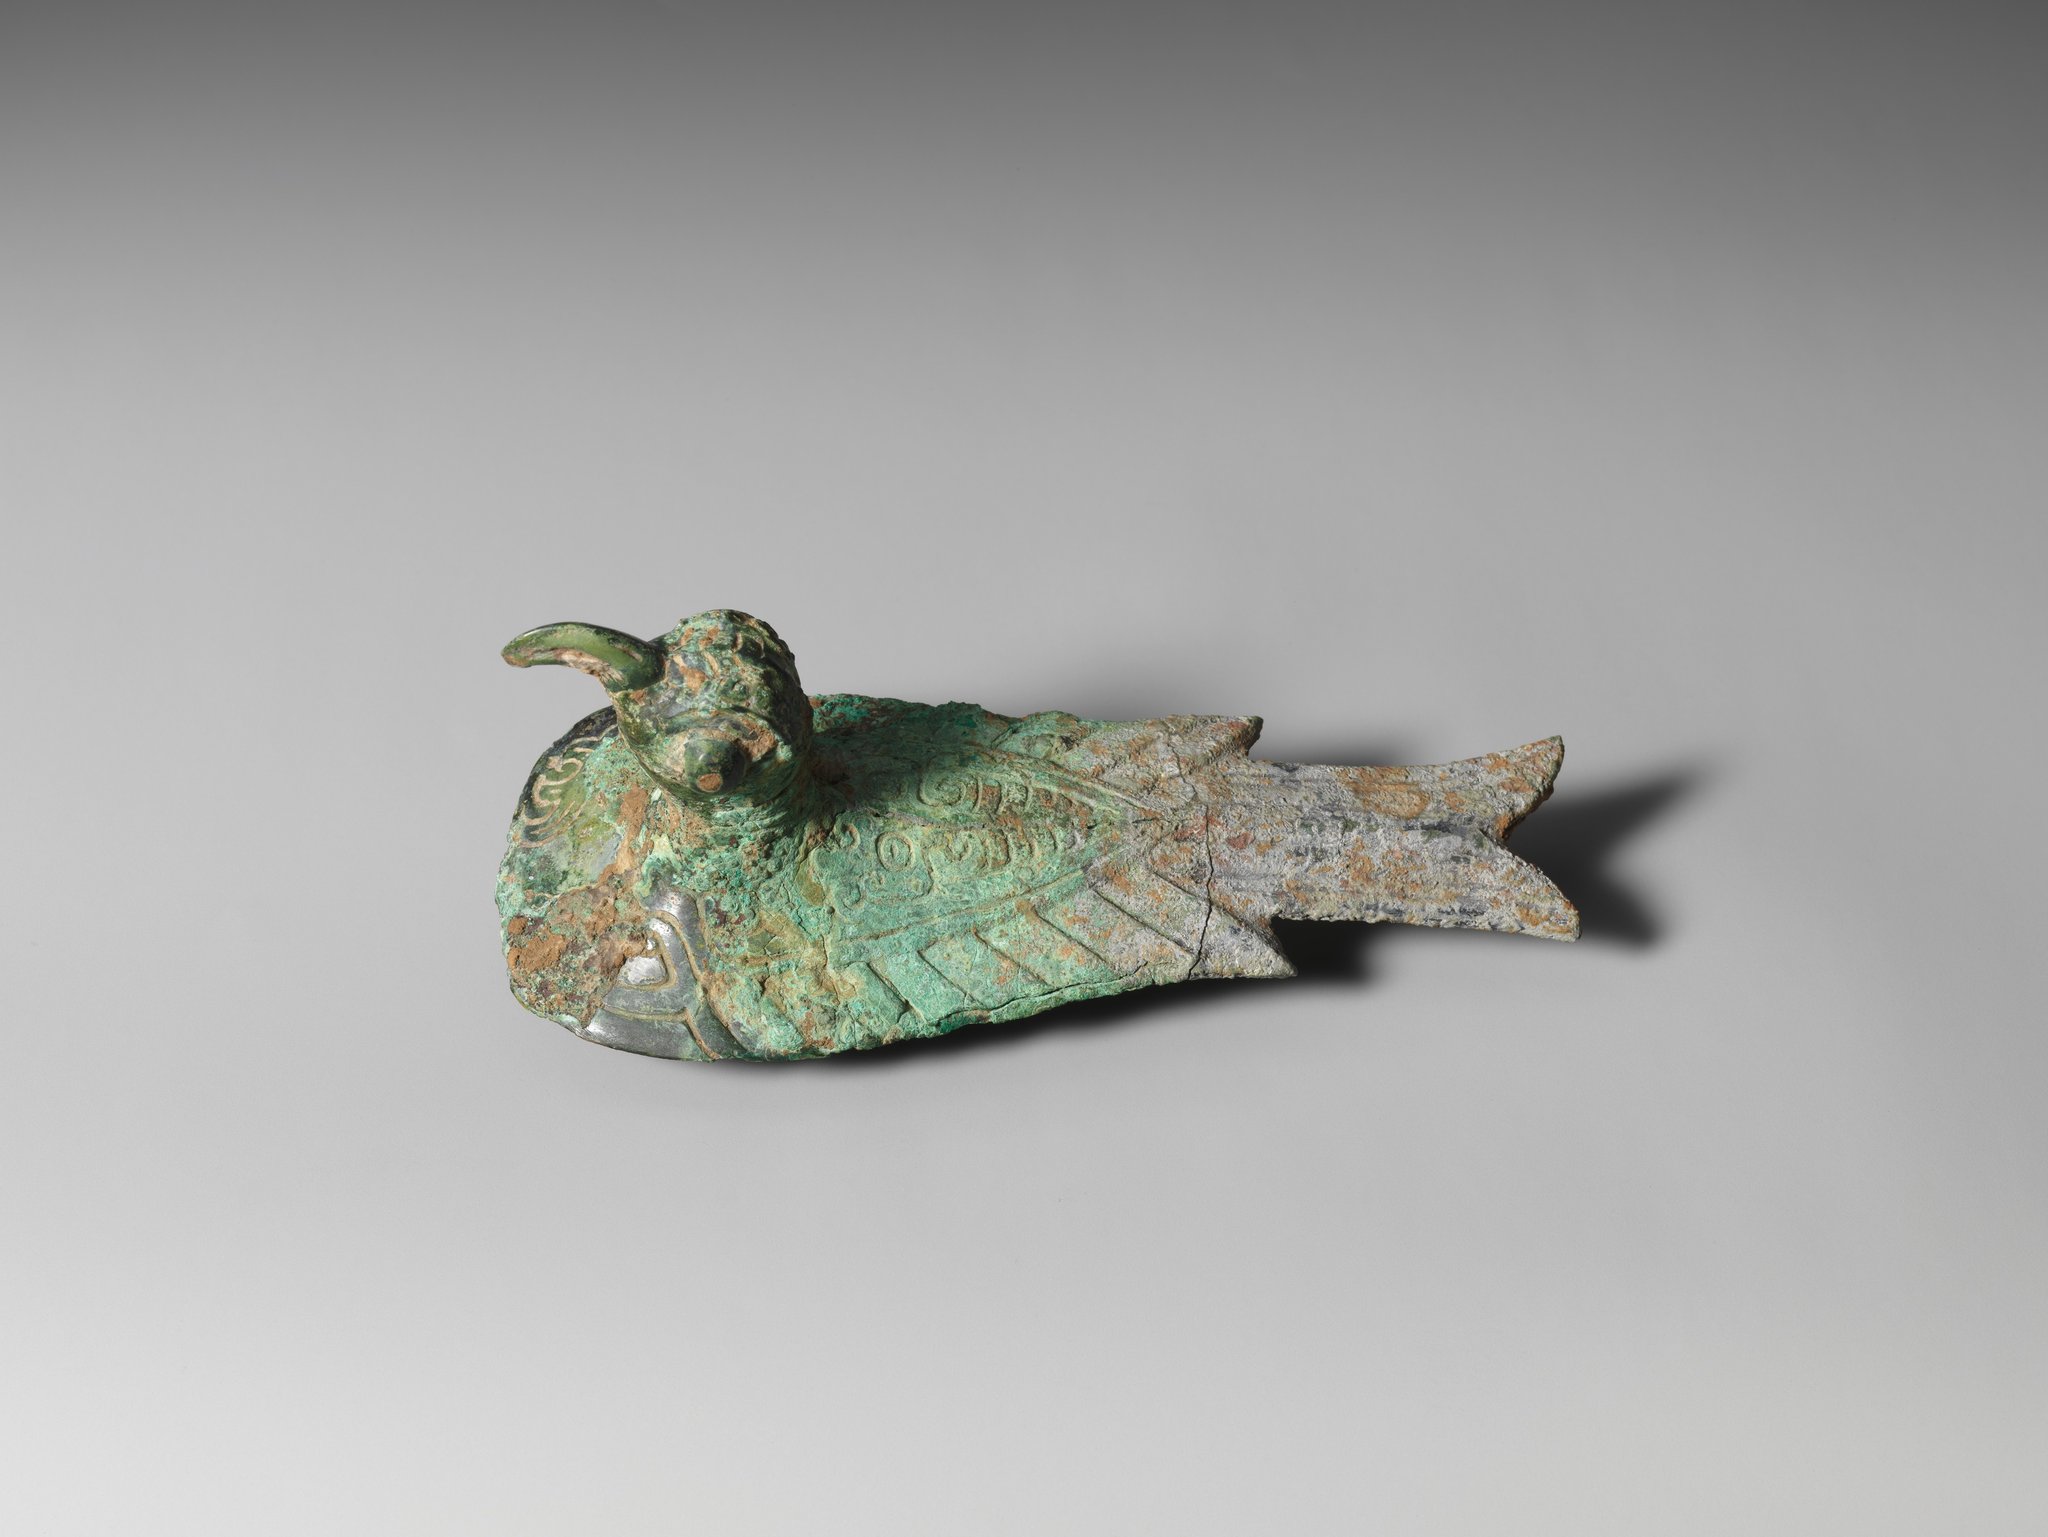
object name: fitting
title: Fitting in the Form of a Bird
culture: chinese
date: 1100-901 BCE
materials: bronze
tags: birds